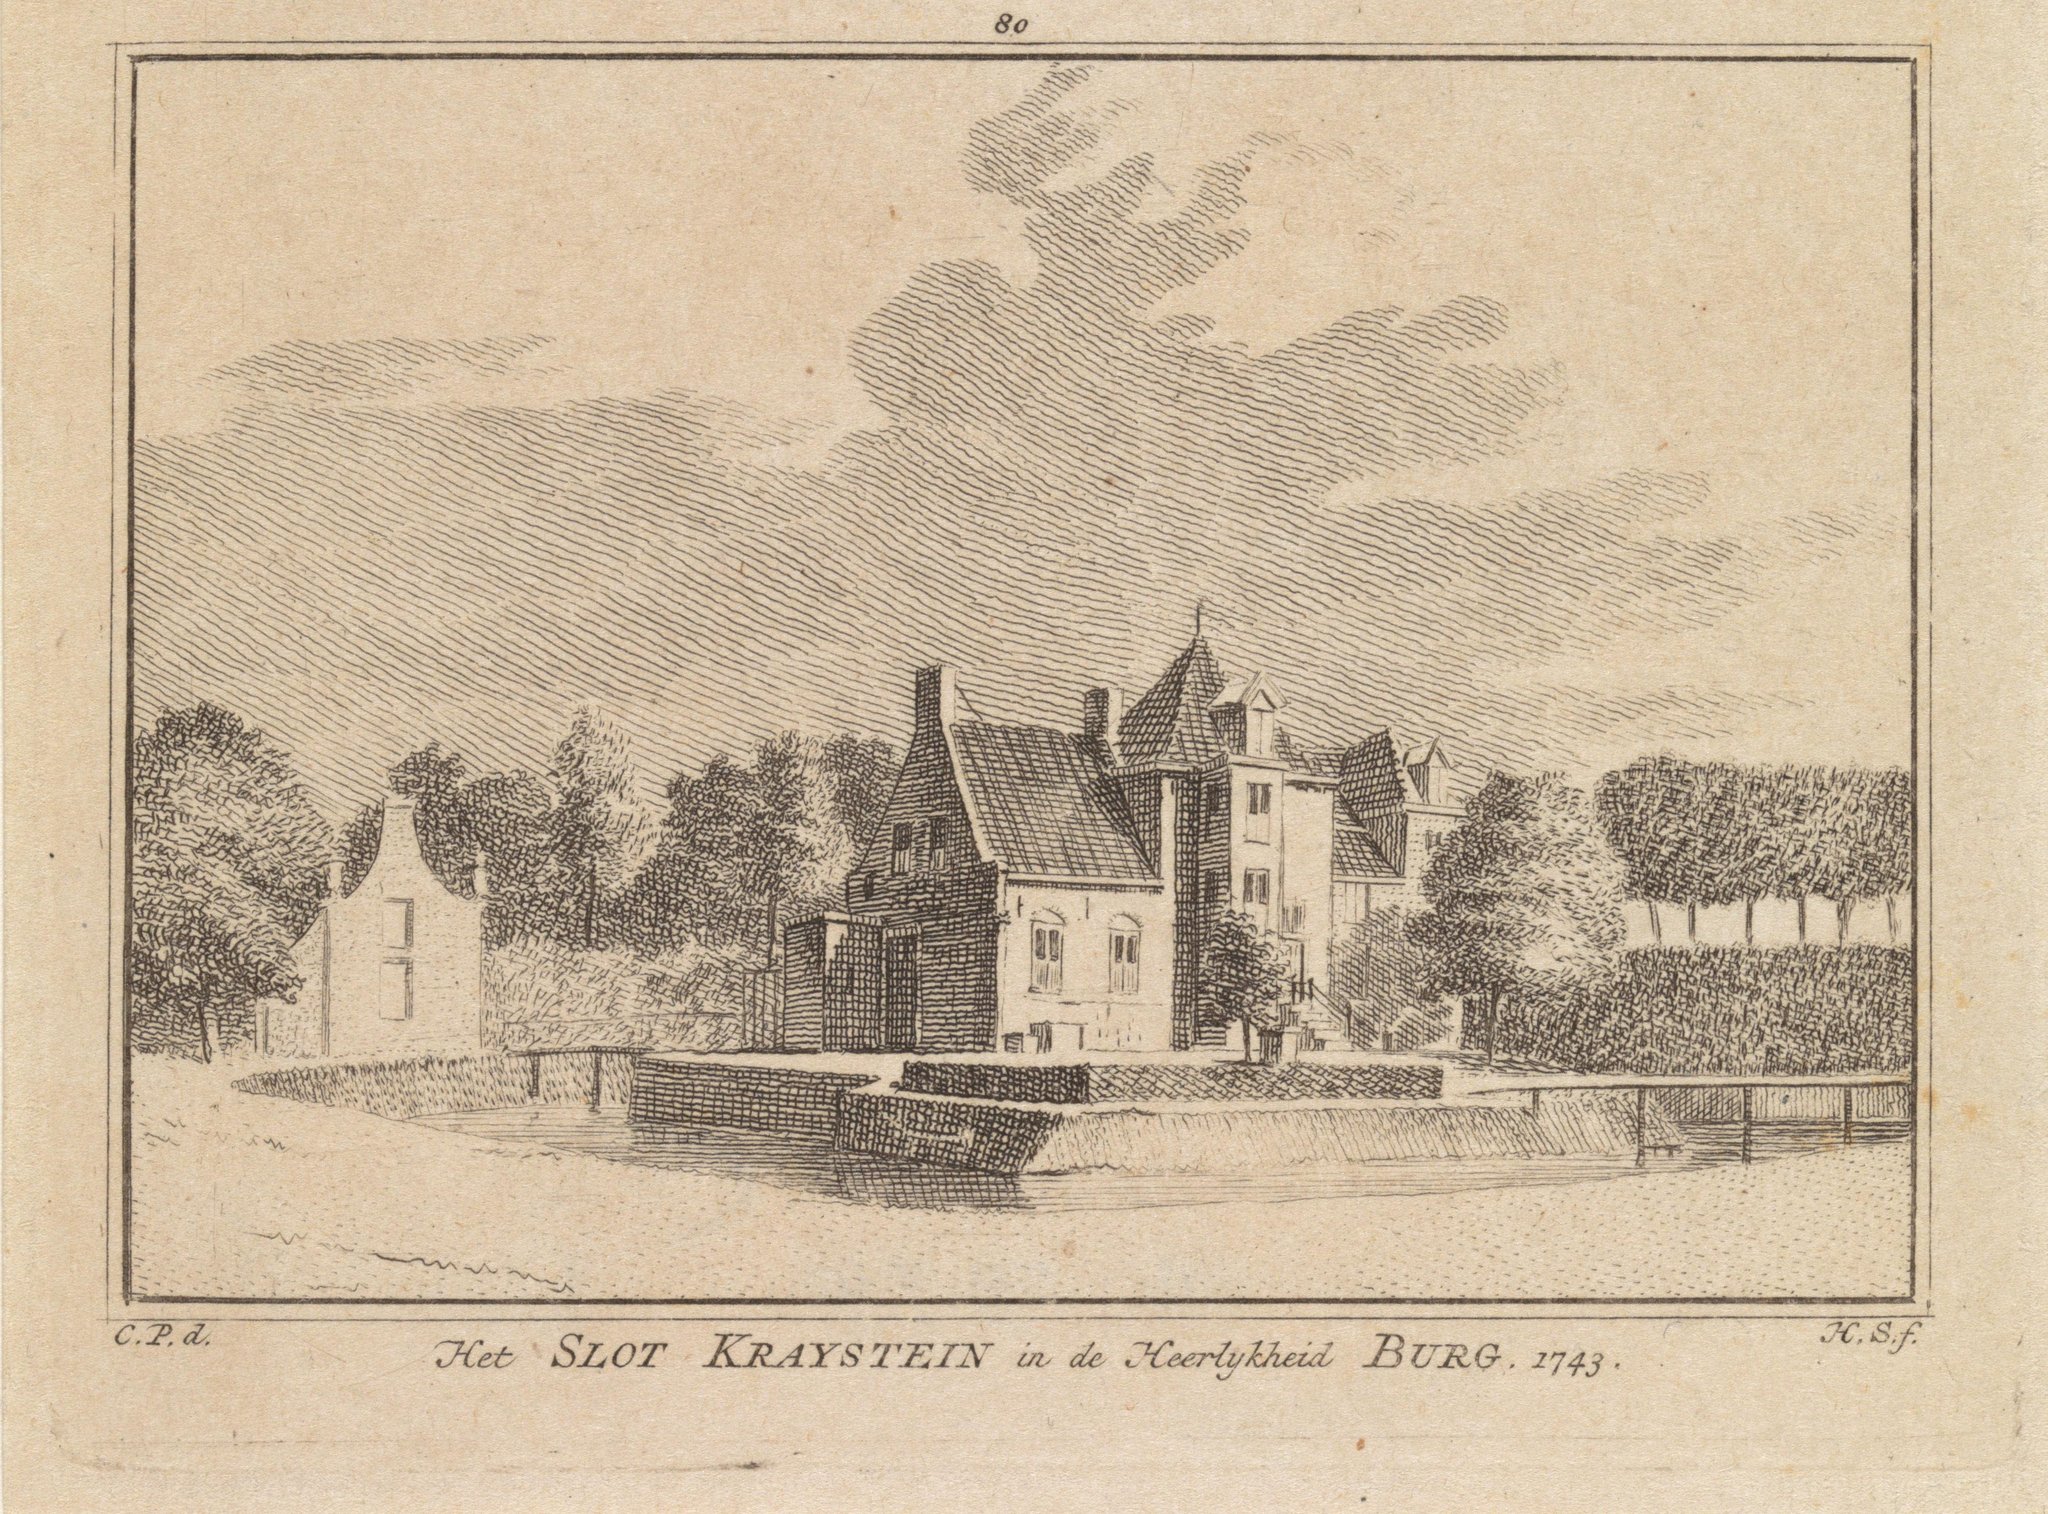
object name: book illustration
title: Het Slot Haamstede en 't Dorp in 't verschiet, 1743/ Het Slot Kraystein in de Heerlijkheid Burg, 1743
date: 1754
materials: paper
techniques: etching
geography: haarlem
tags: castle, church (exterior), slot haamstede, slot kraayenstein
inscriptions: collector's mark: Lugt 2228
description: Prent gebruikt in: Het verheerlykt Nederland of kabinet van hedendaagsche gezigten van steden, dorpen, sloten ... en andere voornaame stad- en landgebouwen, in en omtrent alle de byzondere Vereenigde Nederlandsche Provinciën : gedurende de laatste jaaren door vermaarden kunsttekenaren na het leven getekent en ... in 't koper gebragt ... dienende tot opheldering der beschryvinge van den Tegenwoordigen Staat der Vereenigde Nederlanden. Deel V, 1754. Amsterdam: Isaac Tirion, 1745-1774.